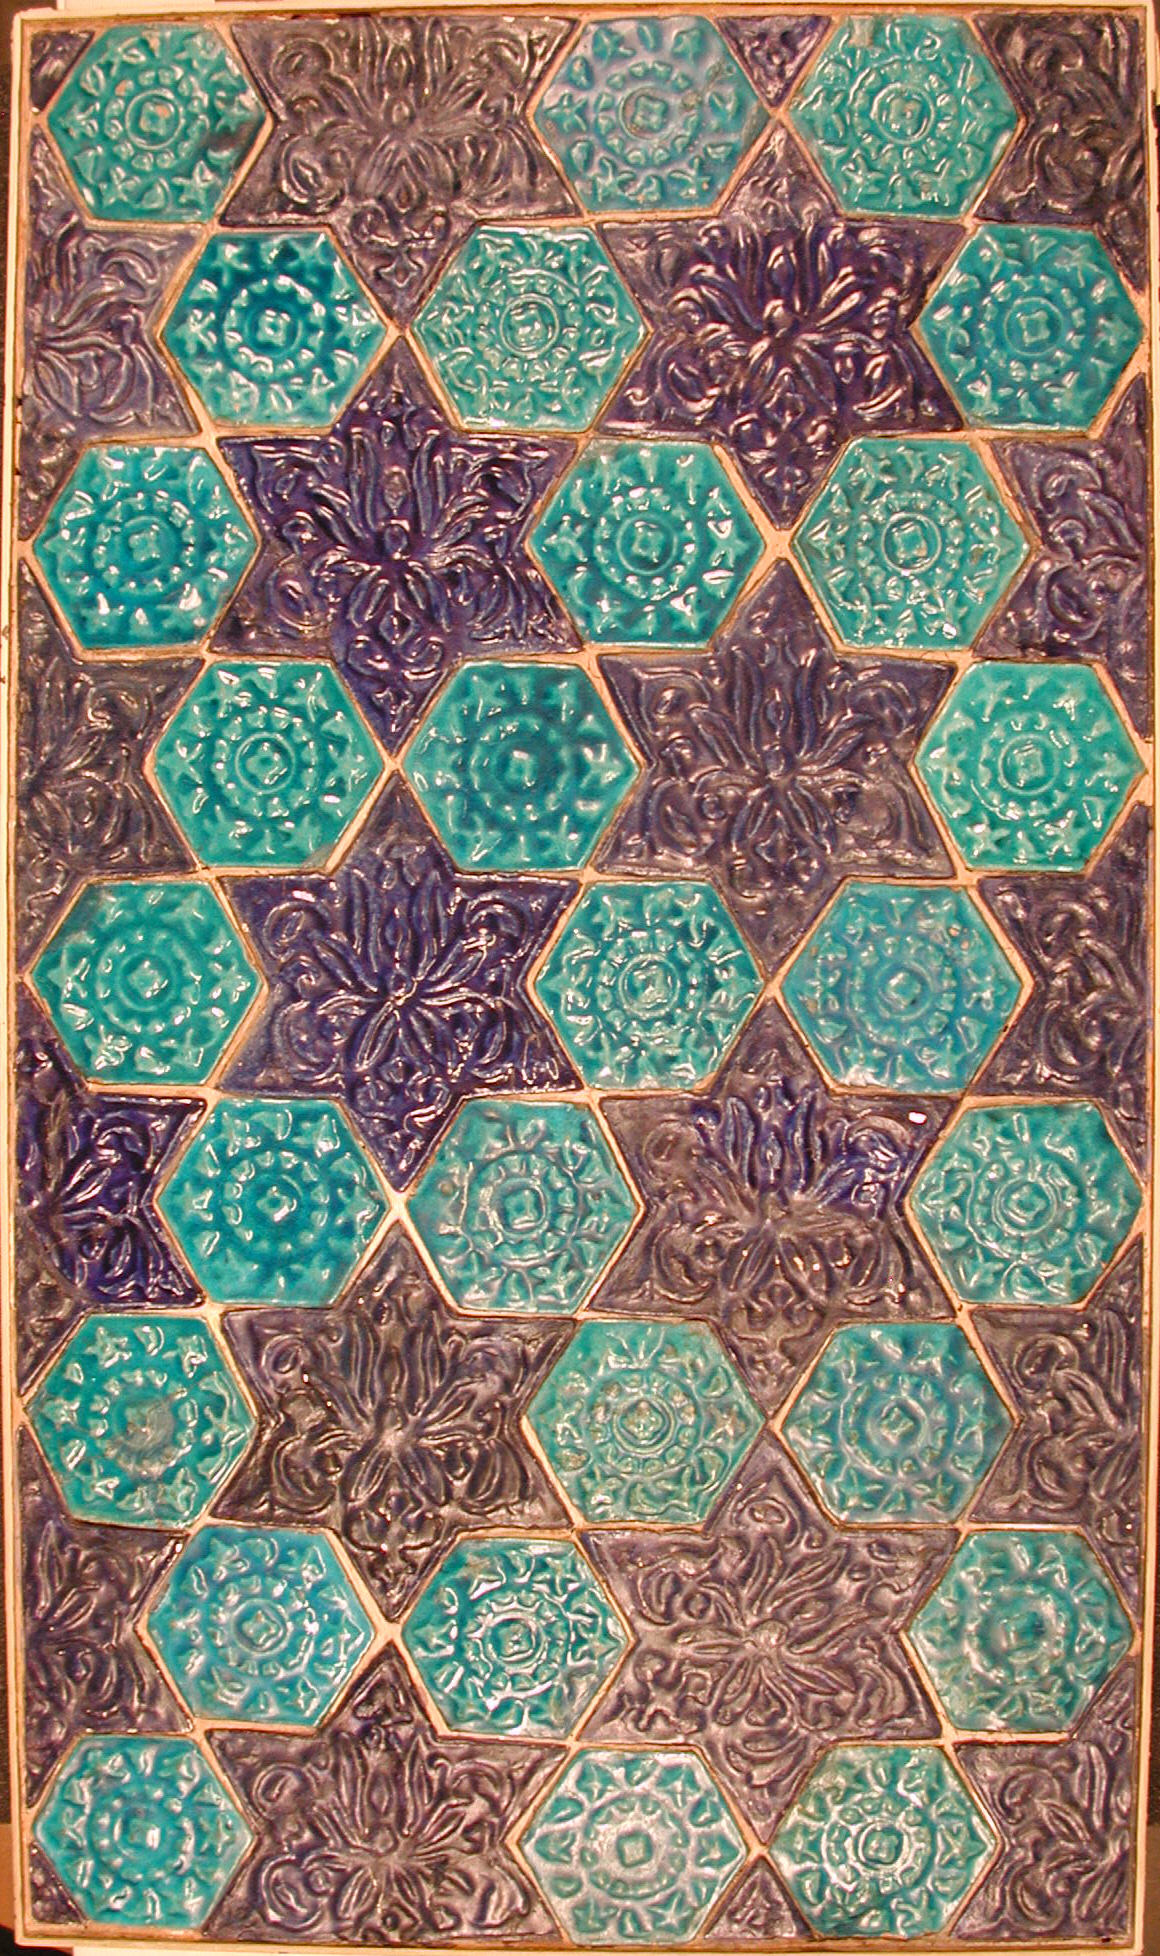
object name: tile panel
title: Star- and Hexagonal-Tile Panel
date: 1267-1400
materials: glaze, stonepaste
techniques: glazing, molding, polychrome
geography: iran